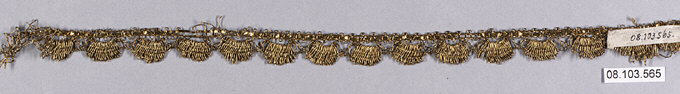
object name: piece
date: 1701-1800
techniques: lace